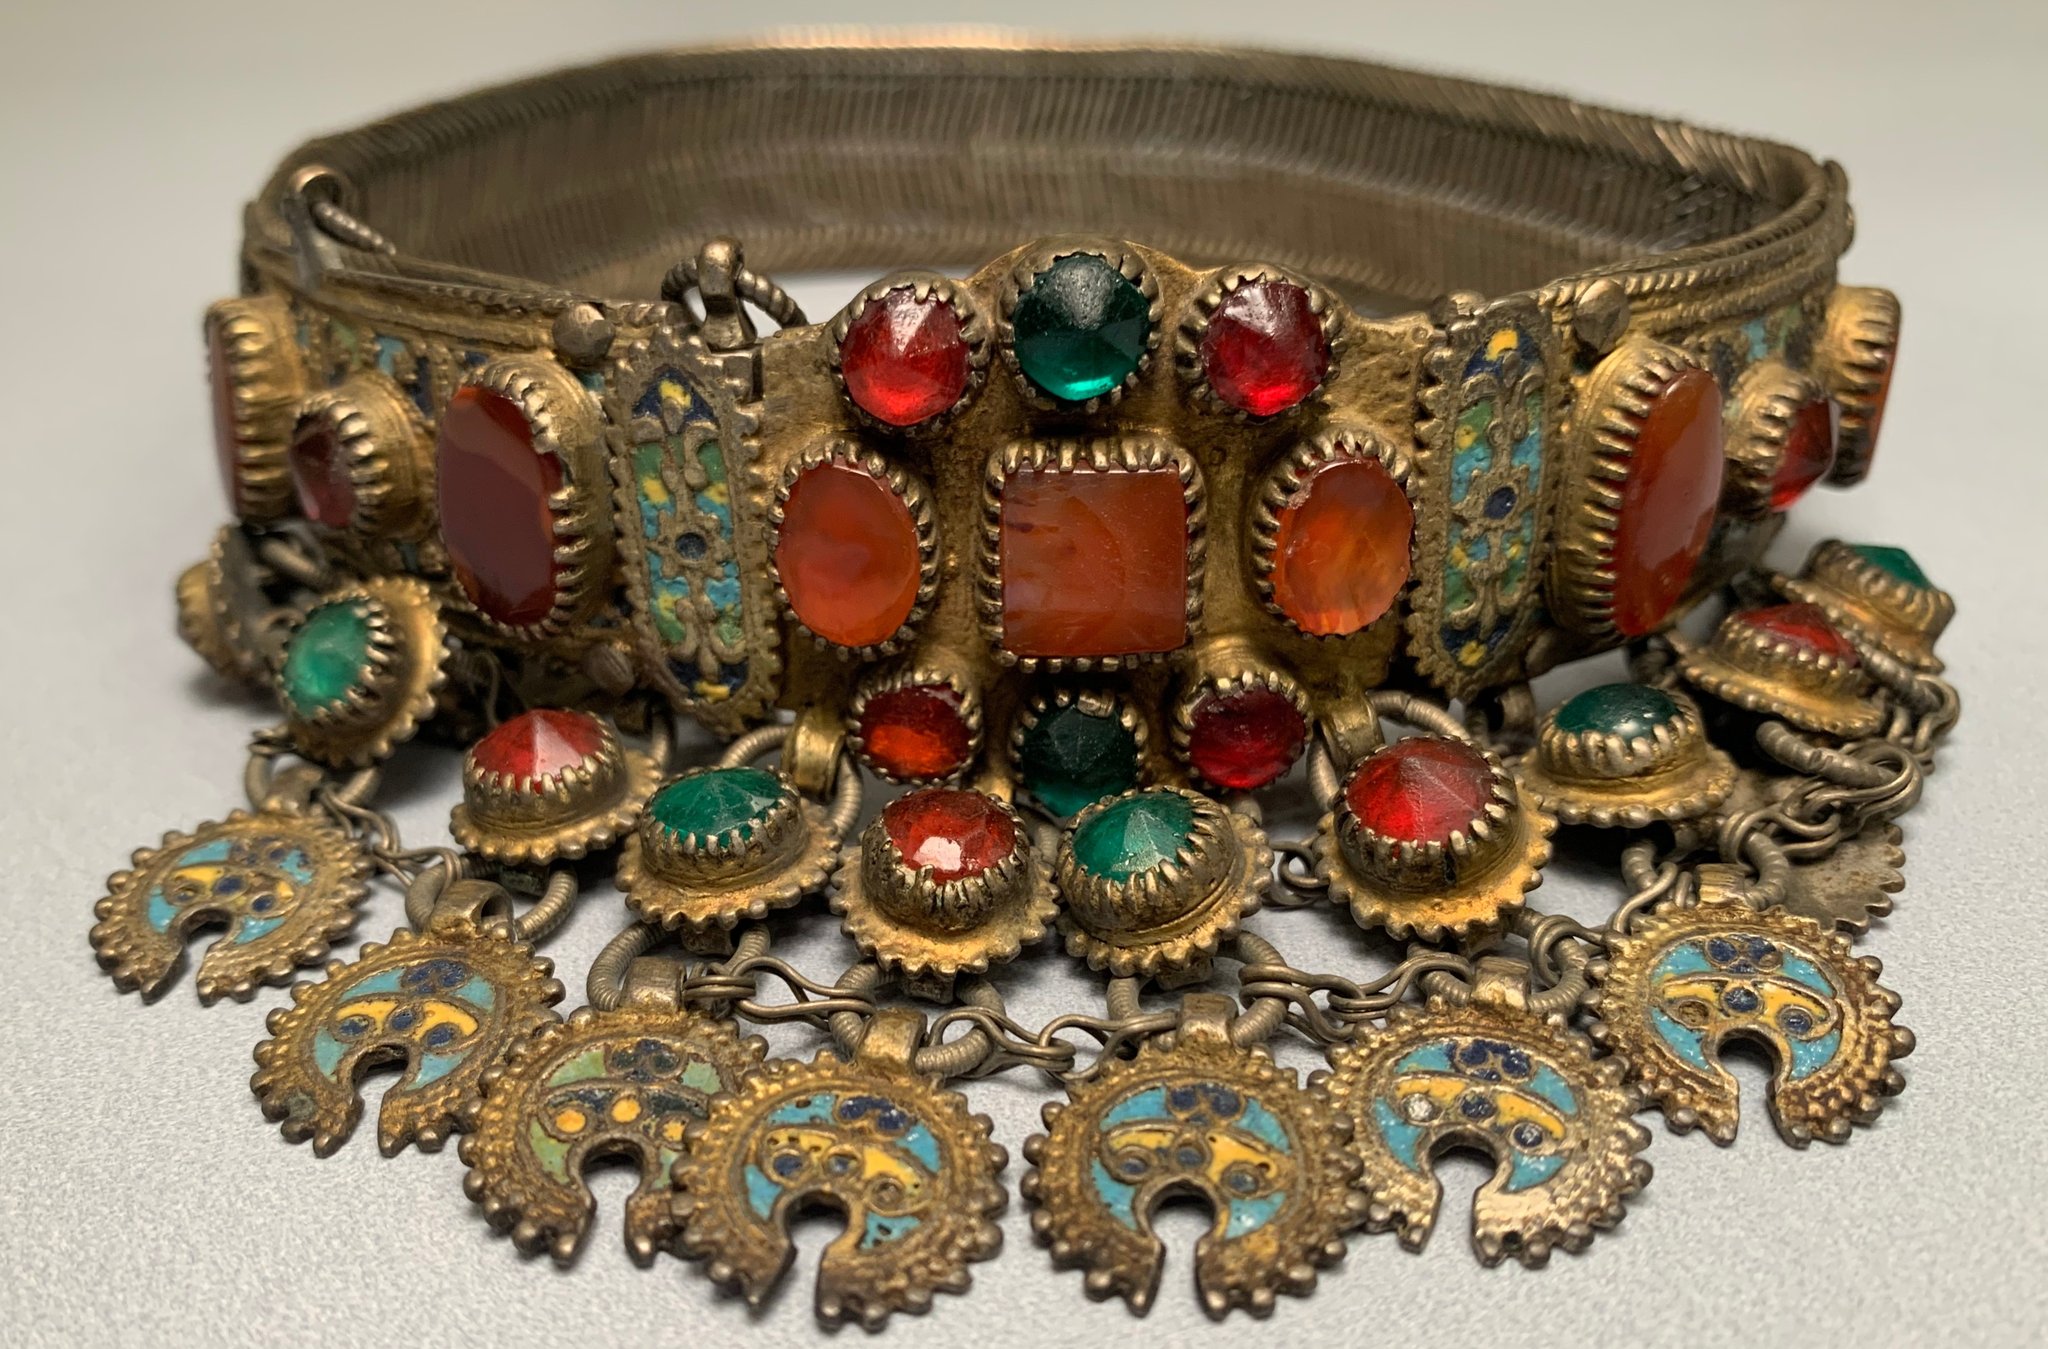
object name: necklet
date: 1801-1900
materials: gemstone, glass, silver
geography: algeria